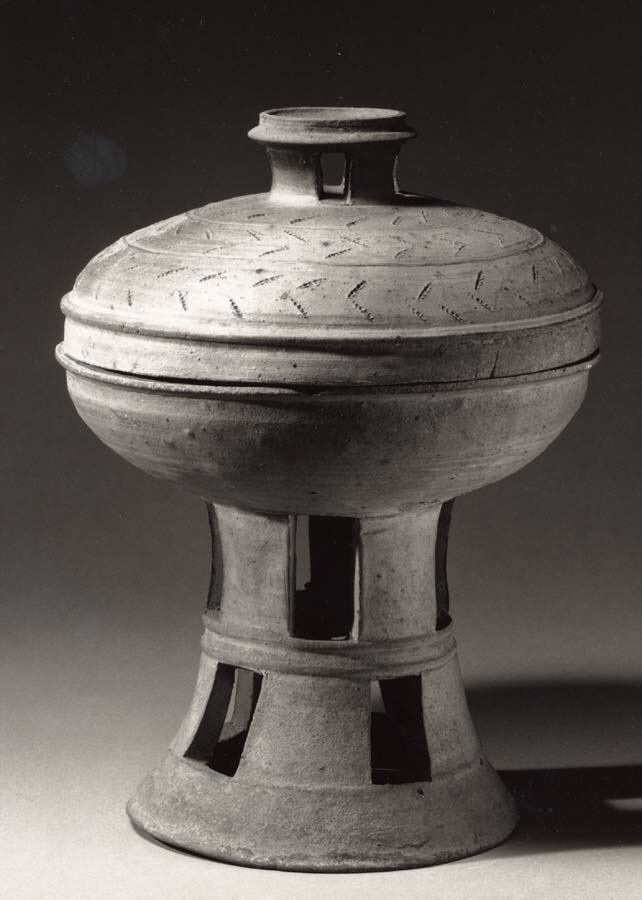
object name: pedestal dish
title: Pedestal dish with cover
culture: korean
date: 401-600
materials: stoneware